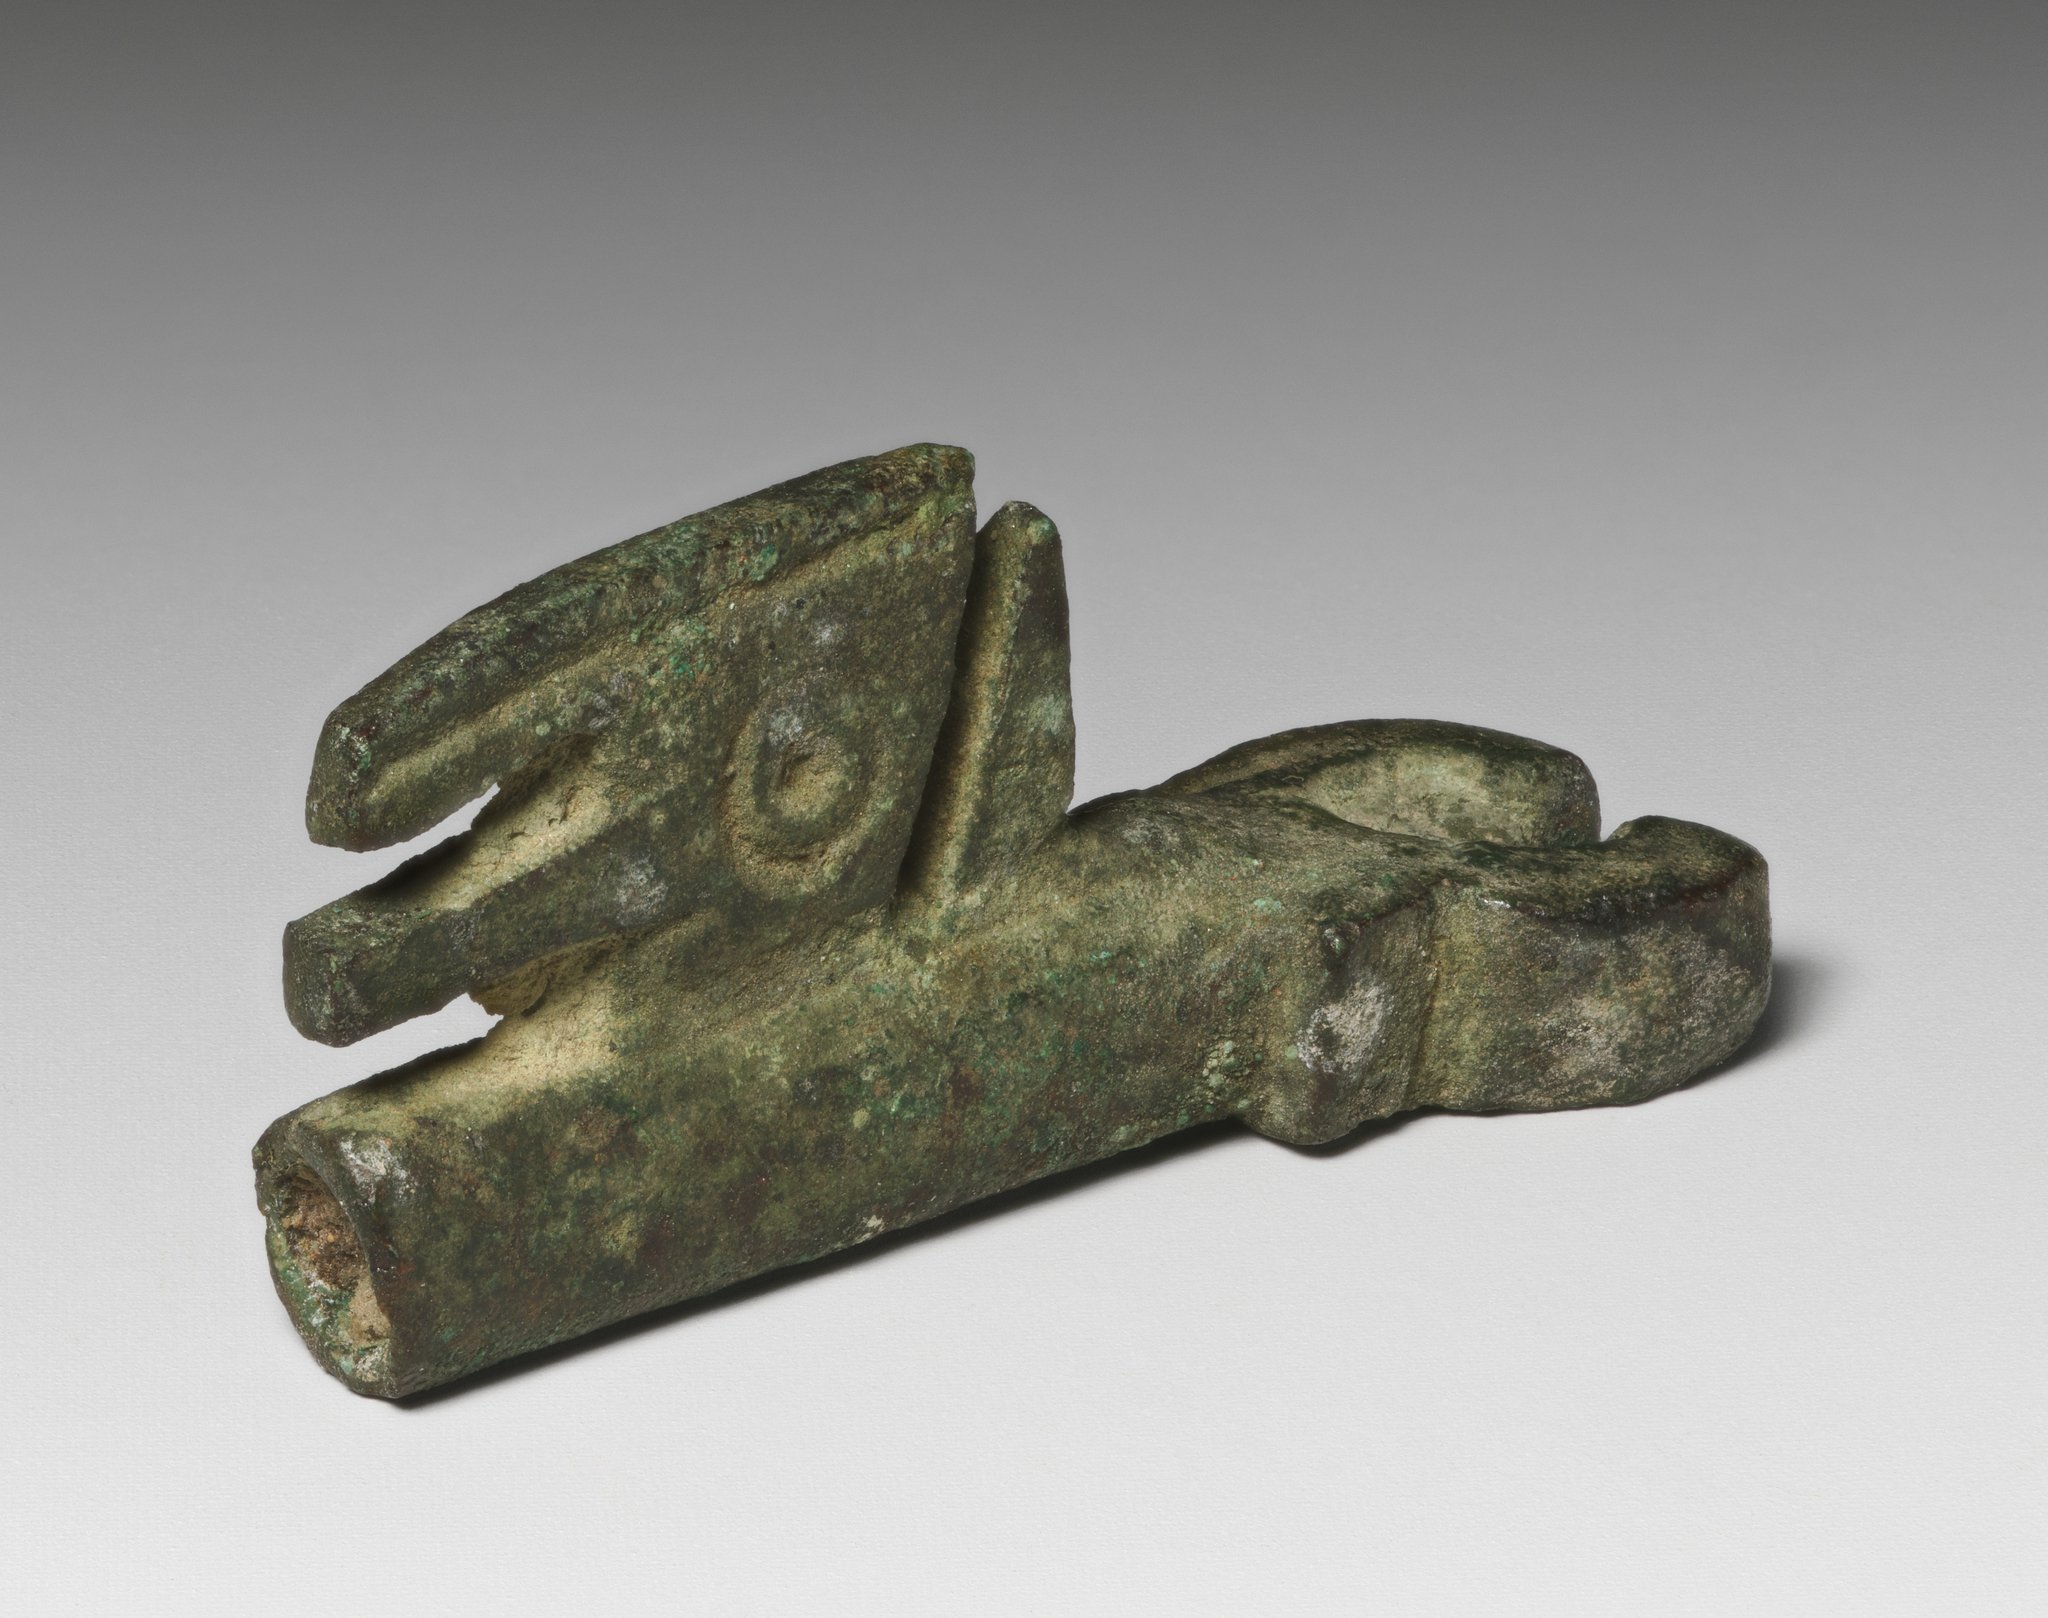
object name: key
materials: copper alloy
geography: egypt